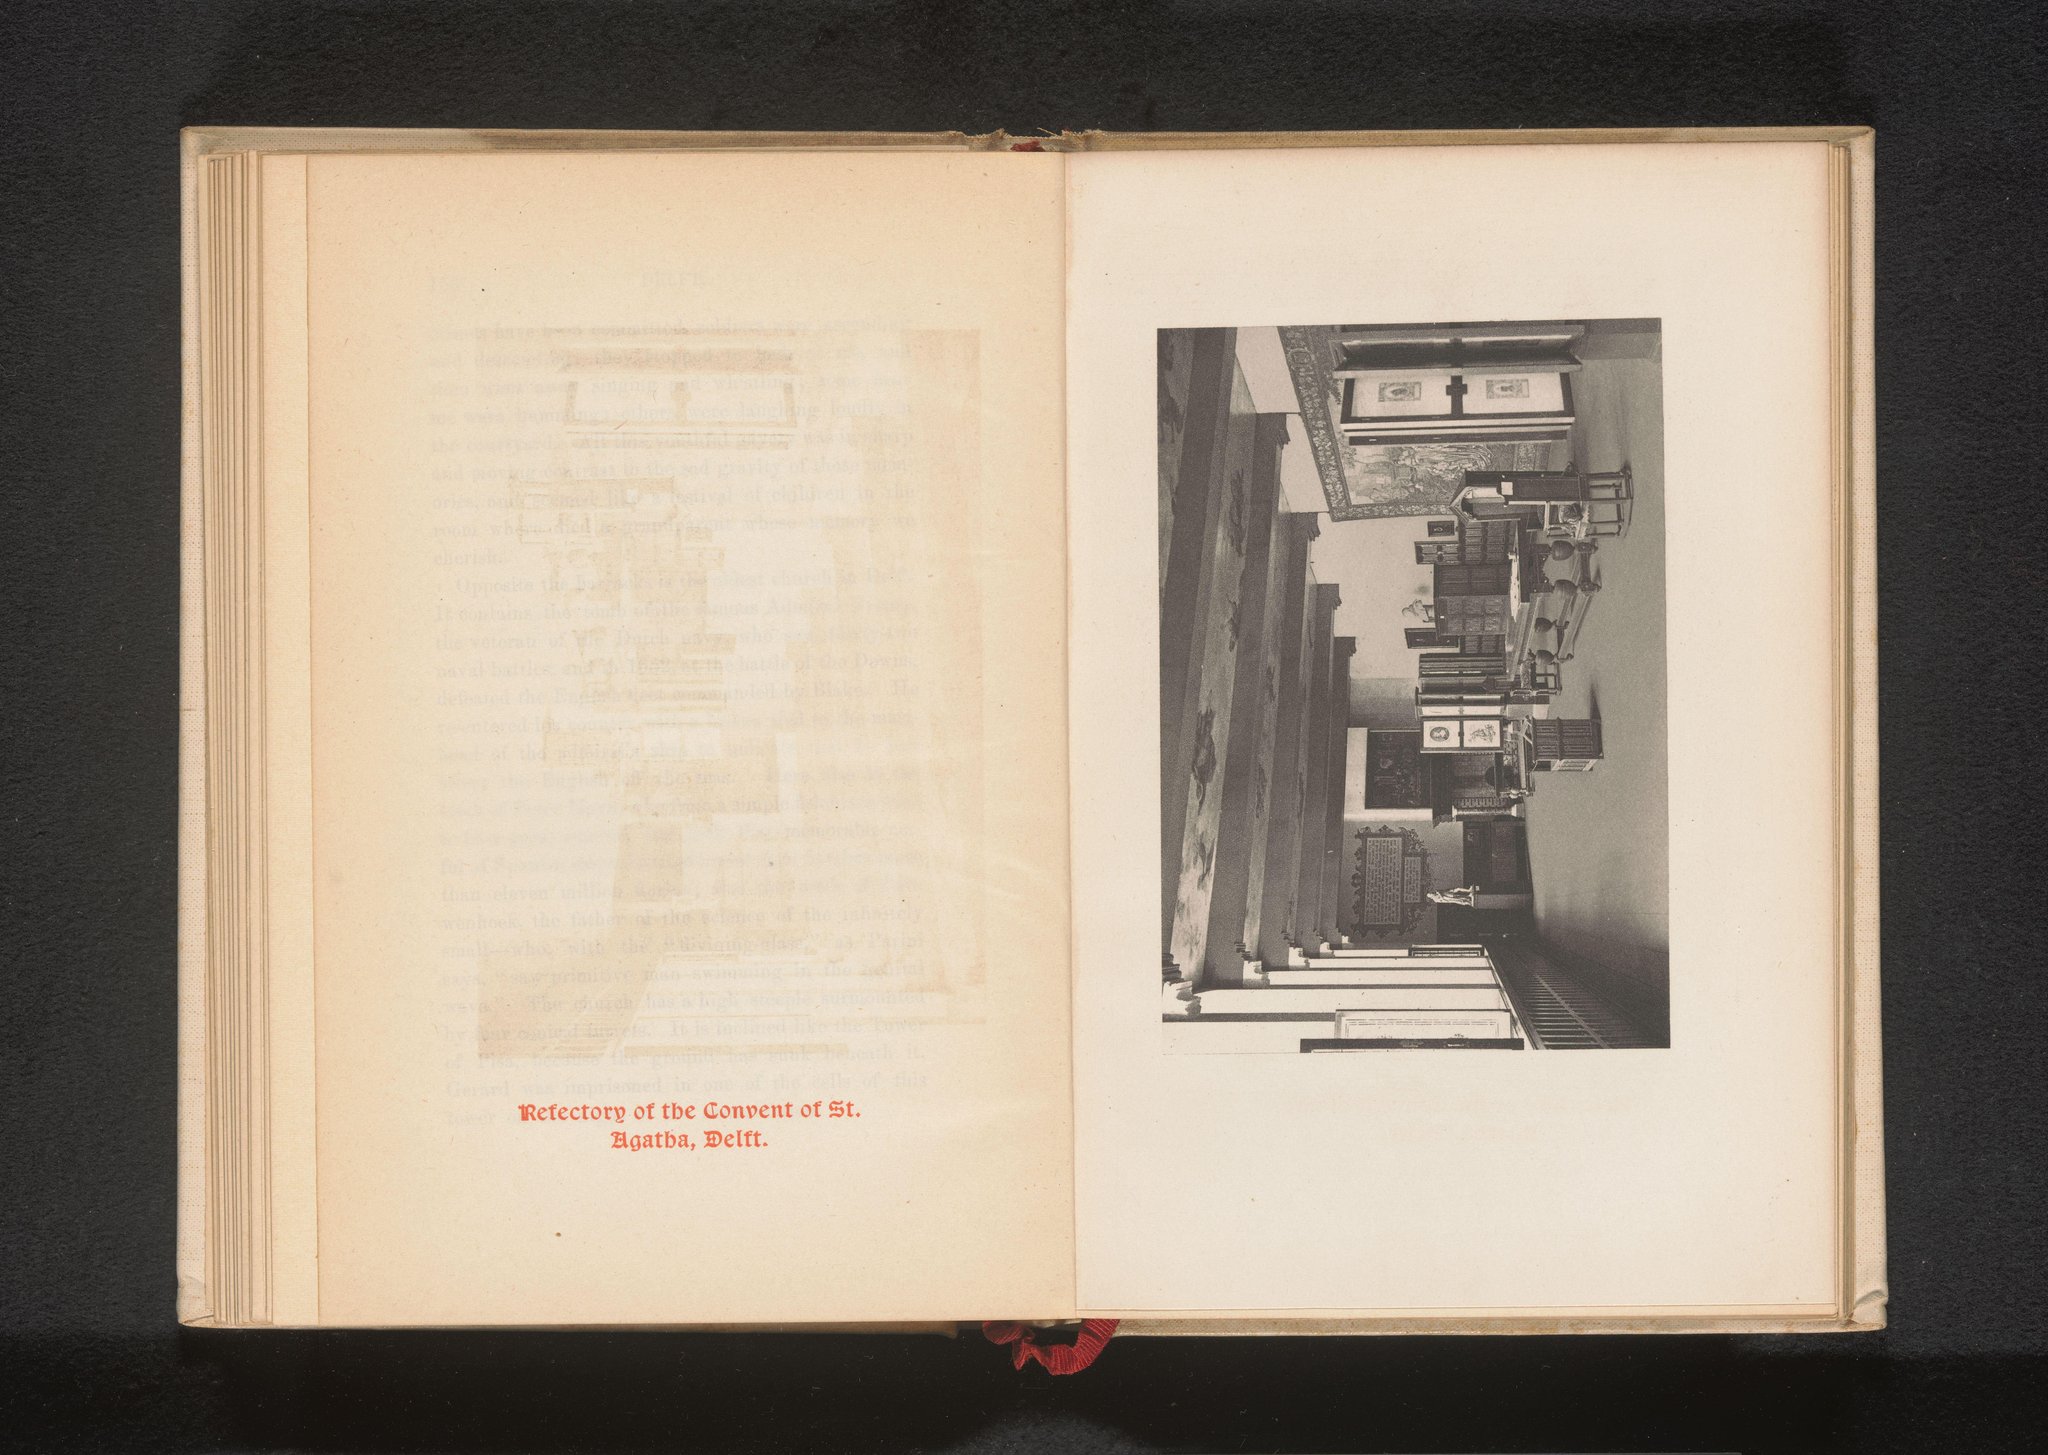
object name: page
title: Refter van het voormalig Sint-Agathaklooster te Delft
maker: charles l. mitchell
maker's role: fotograaf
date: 1884-1894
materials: paper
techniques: photoaquatint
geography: delft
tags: refectory ~ monastery, interior ~ representation of a building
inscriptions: title: ‘Refectory of the Convent of St. Agatha, Delft.’